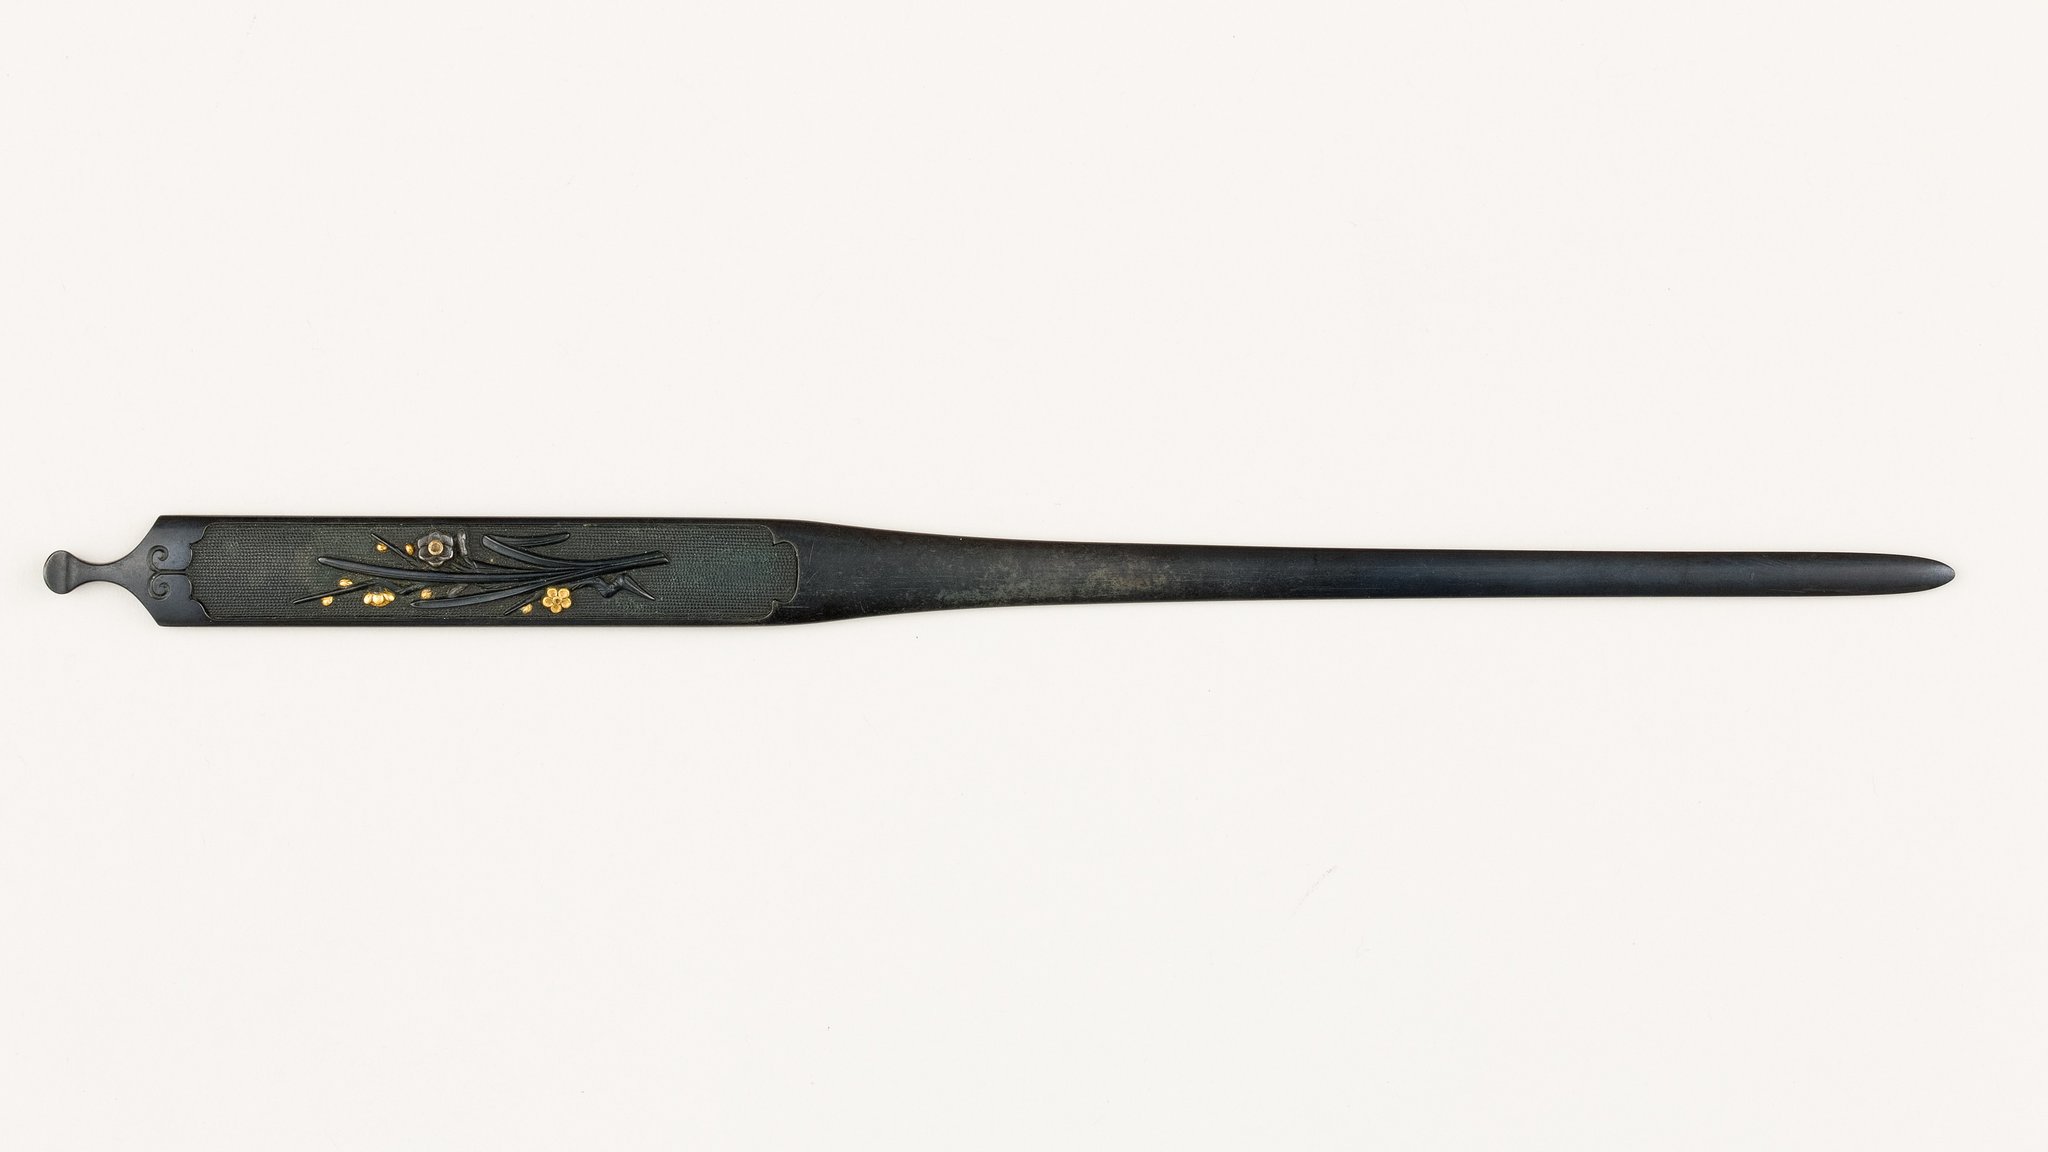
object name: hair dressing tool kogai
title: Hair Dressing Tool (Kogai)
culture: japanese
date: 1501-1600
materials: gold alloy, gold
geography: japan